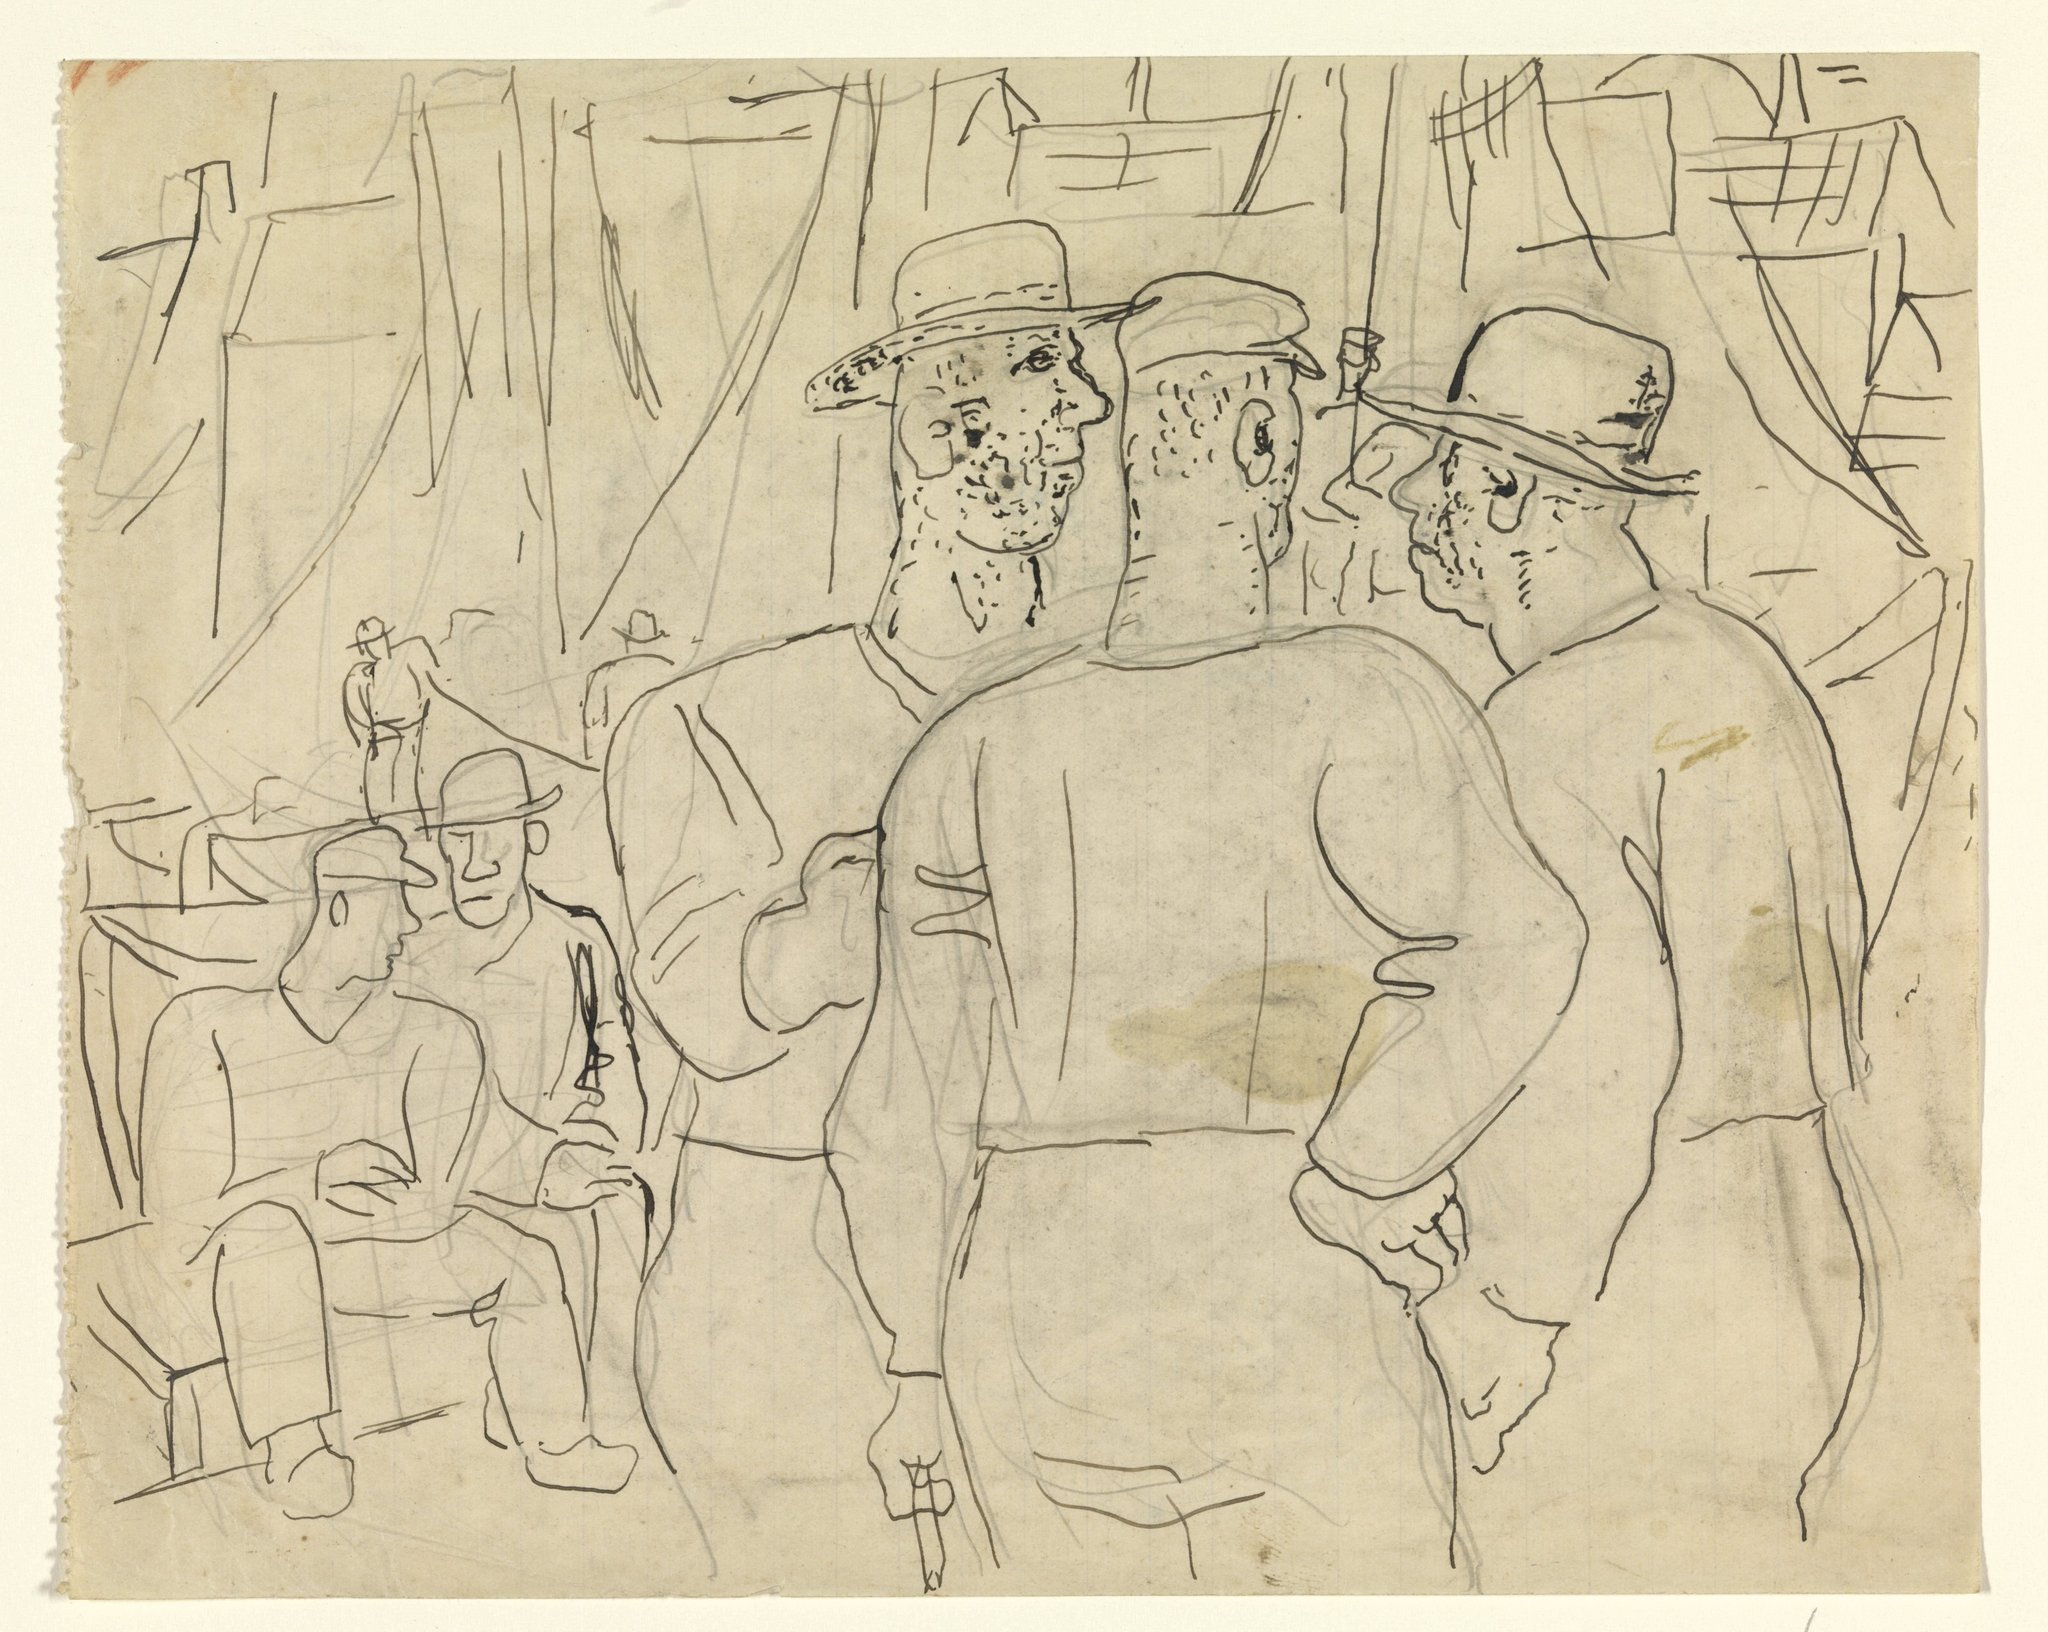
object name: drawing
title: Vissers in een haven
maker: leo gestel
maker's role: draughtsman, print maker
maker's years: 1881-1941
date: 1891-1941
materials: ink, paper, pencil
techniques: pen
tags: ships (in general), fisherman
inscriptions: collector's mark: Lugt 2228